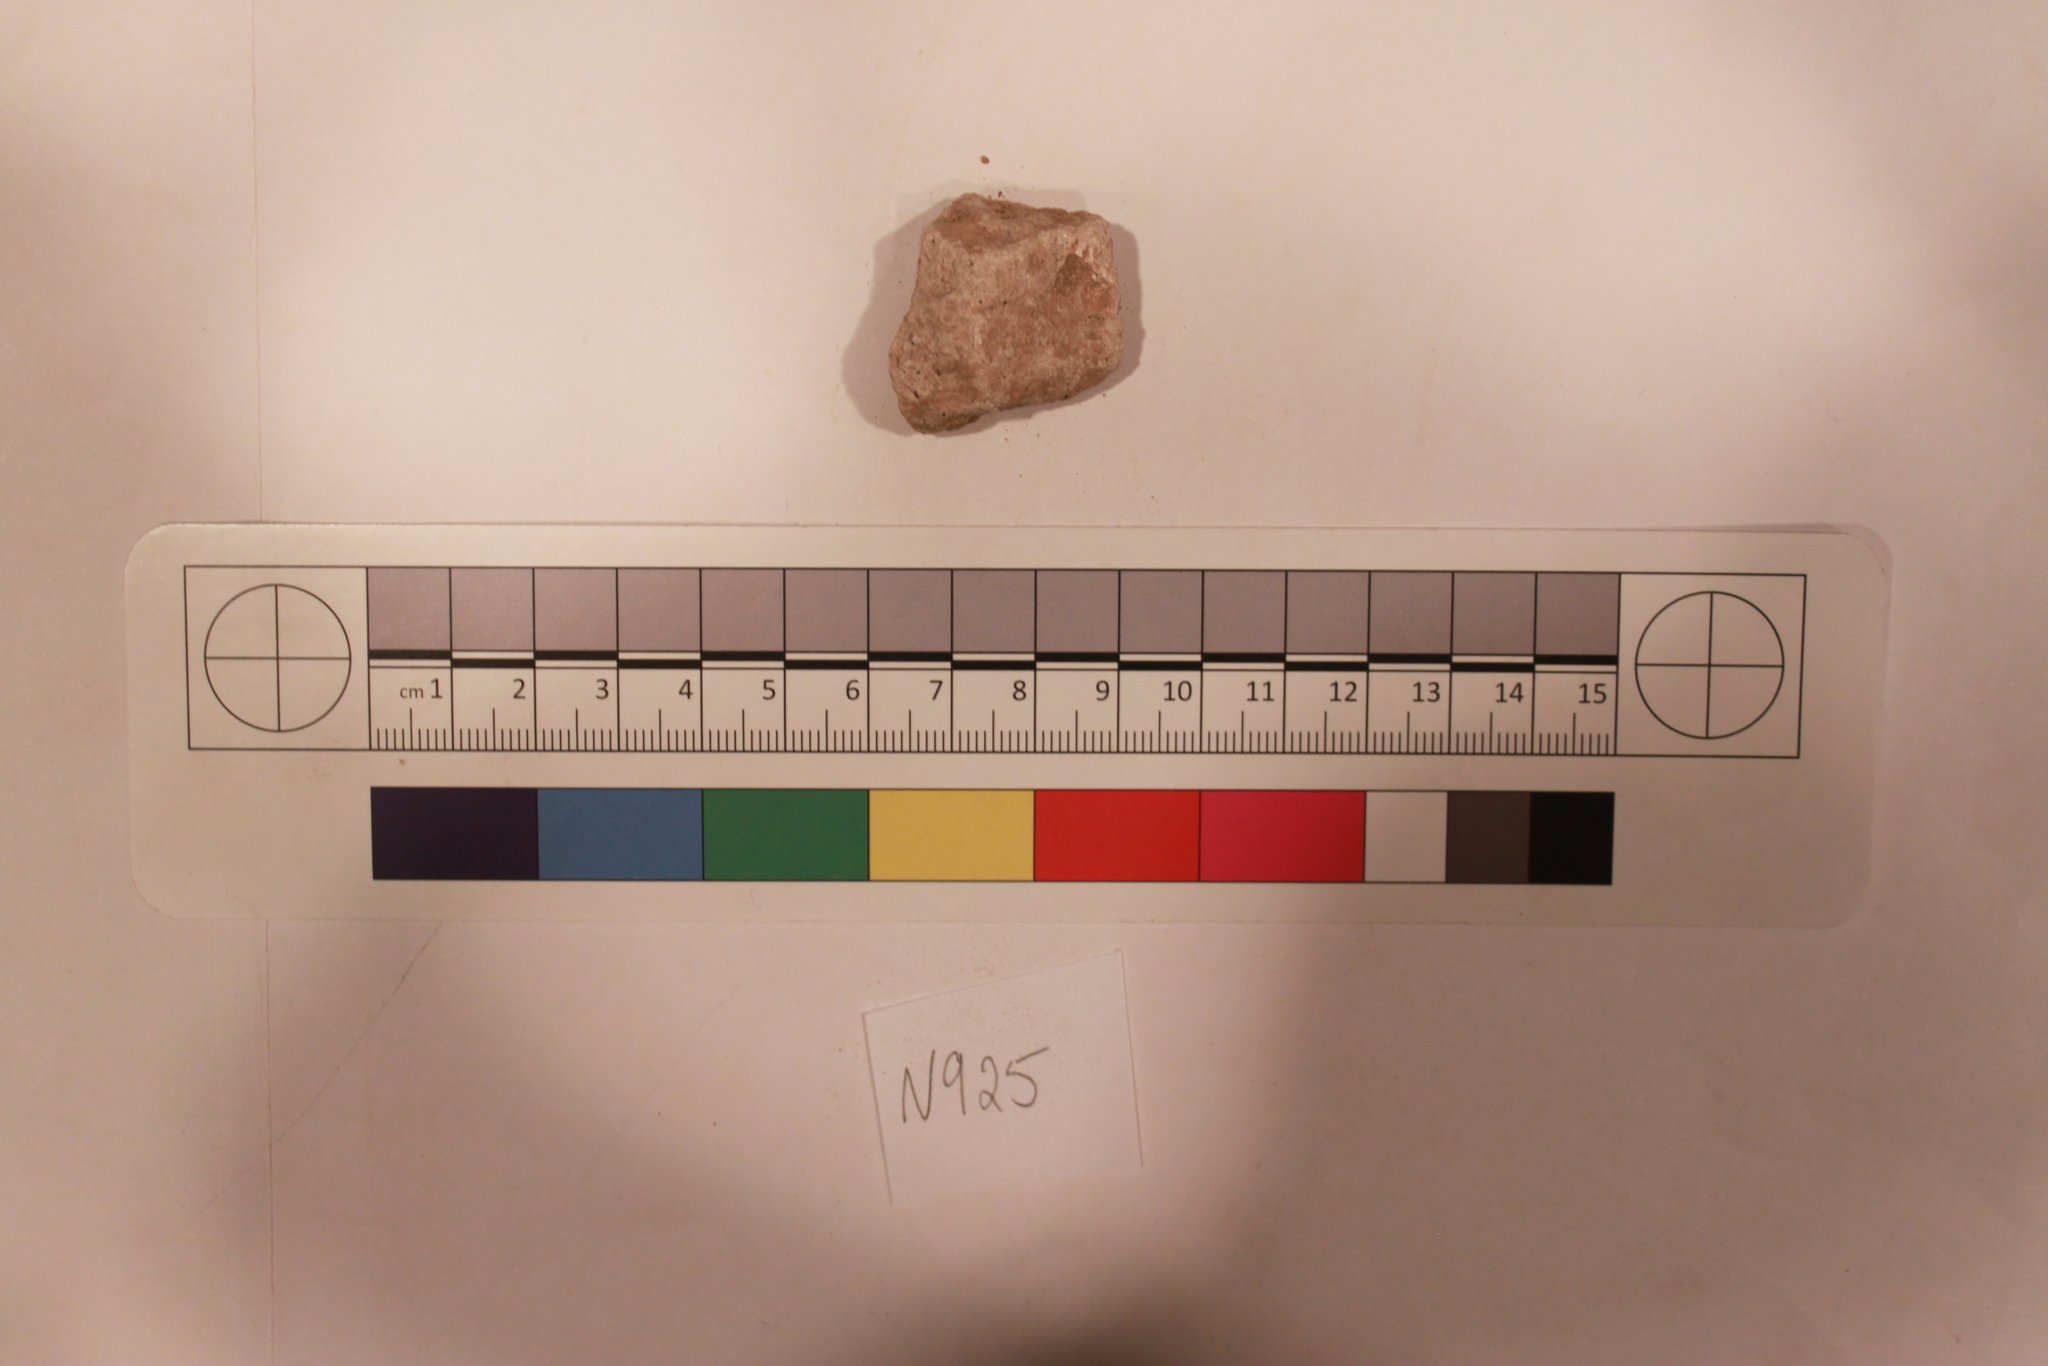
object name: fragment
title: Stucco Fragment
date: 701-1200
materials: plaster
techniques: carving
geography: iran